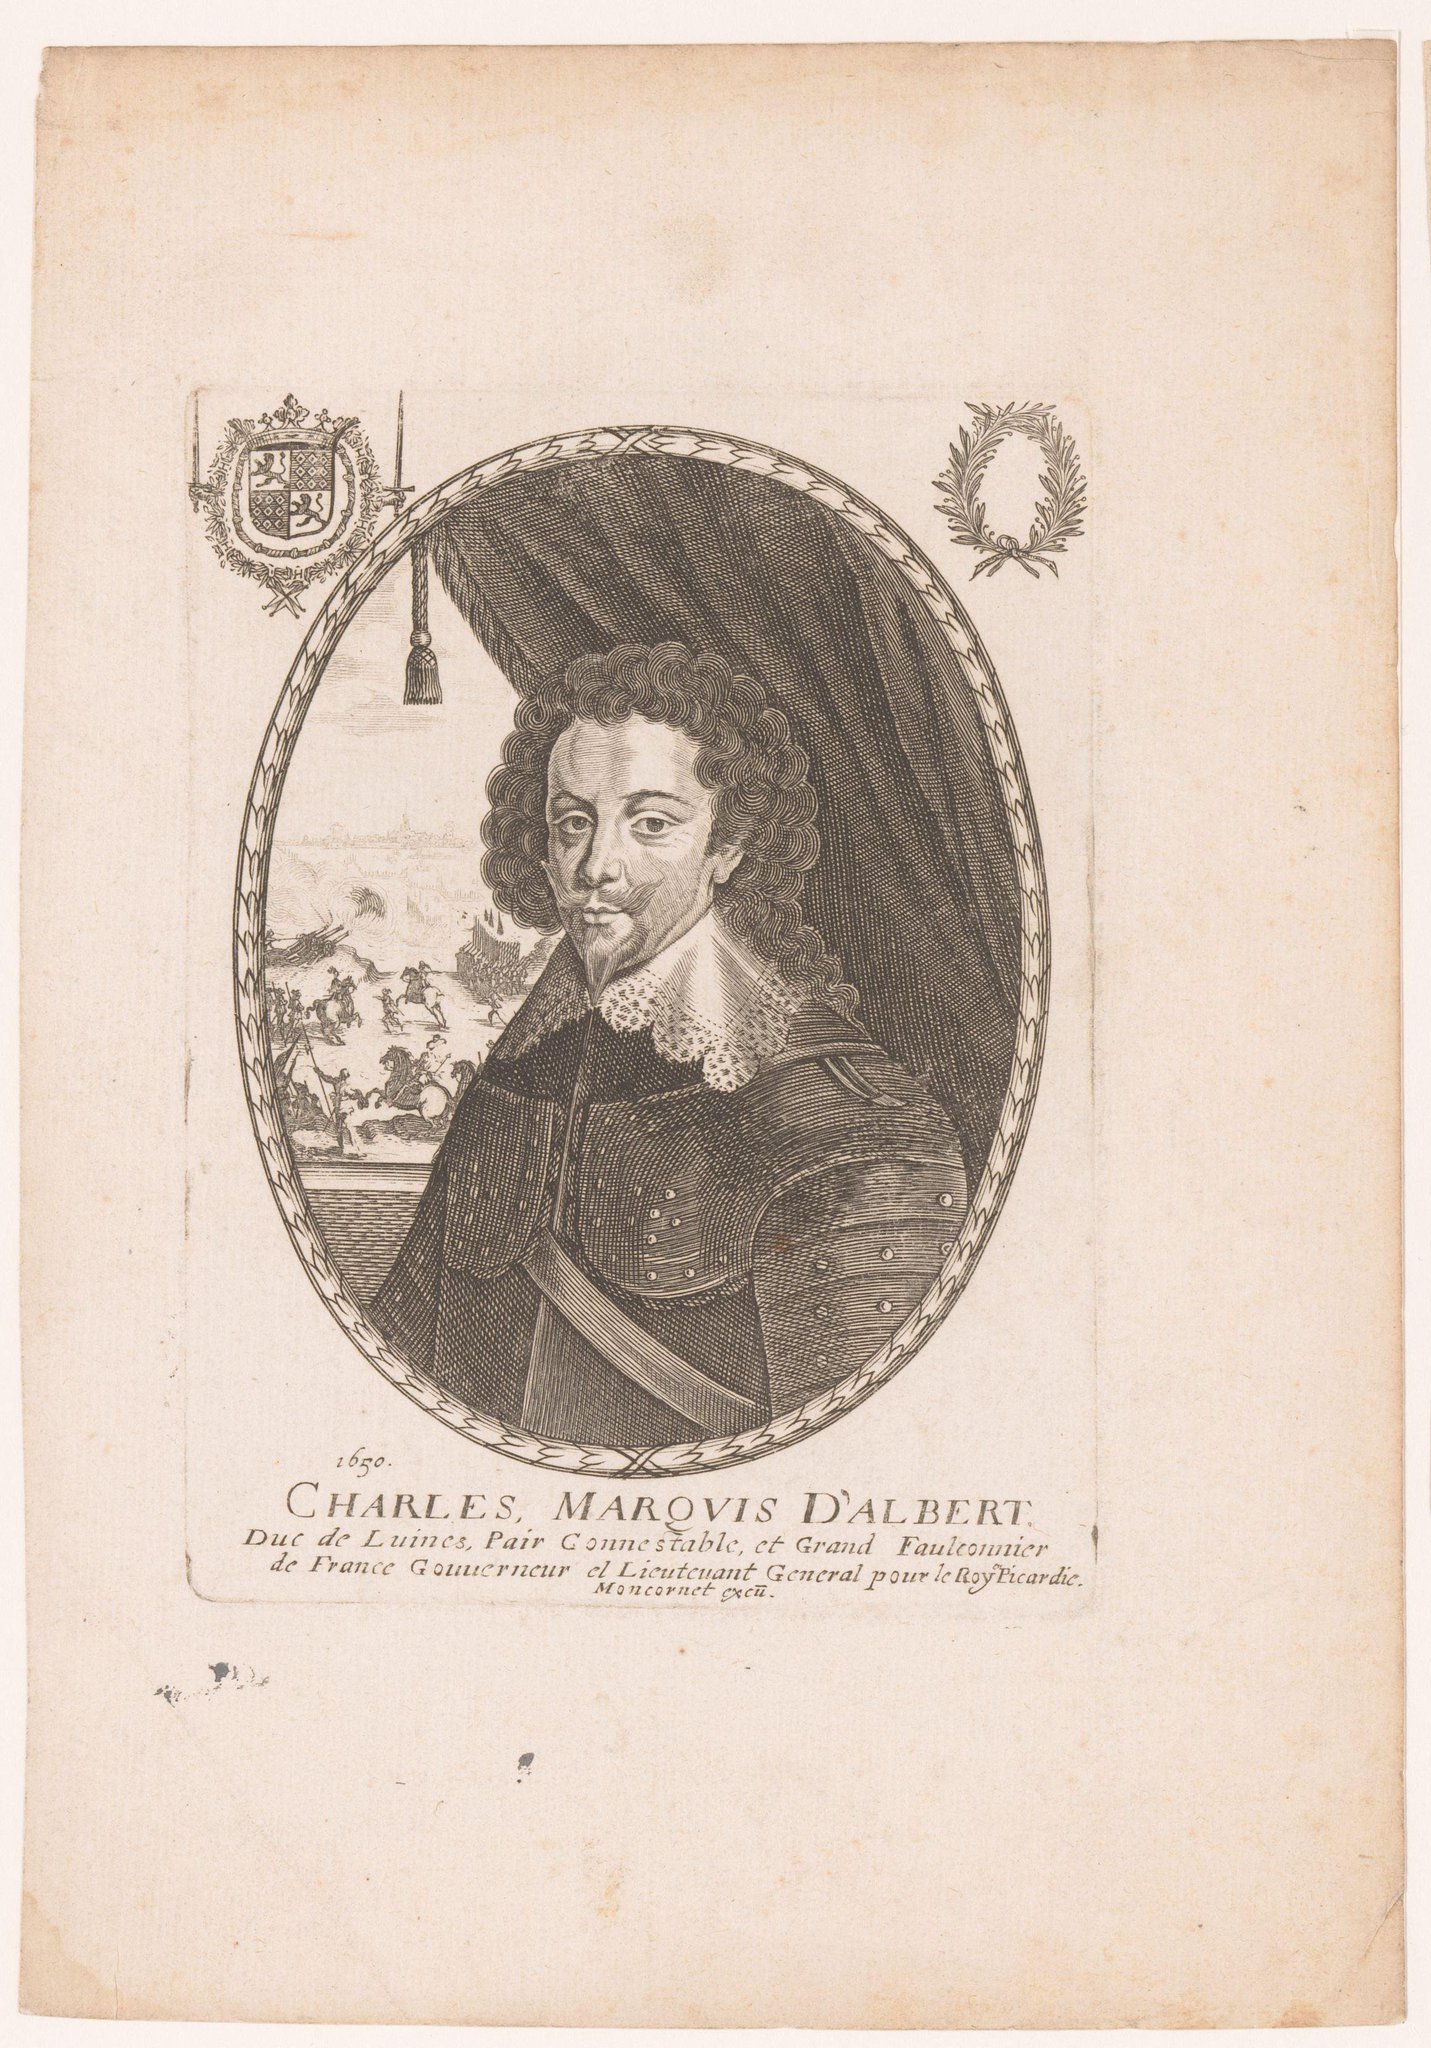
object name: print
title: Portret van Charles de Luynes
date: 1650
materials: paper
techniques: engraving, etching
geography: paris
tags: historical persons, armorial bearing, heraldry, nobility and patriciate; chivalry, knighthood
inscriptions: collector's mark: Lugt 2228